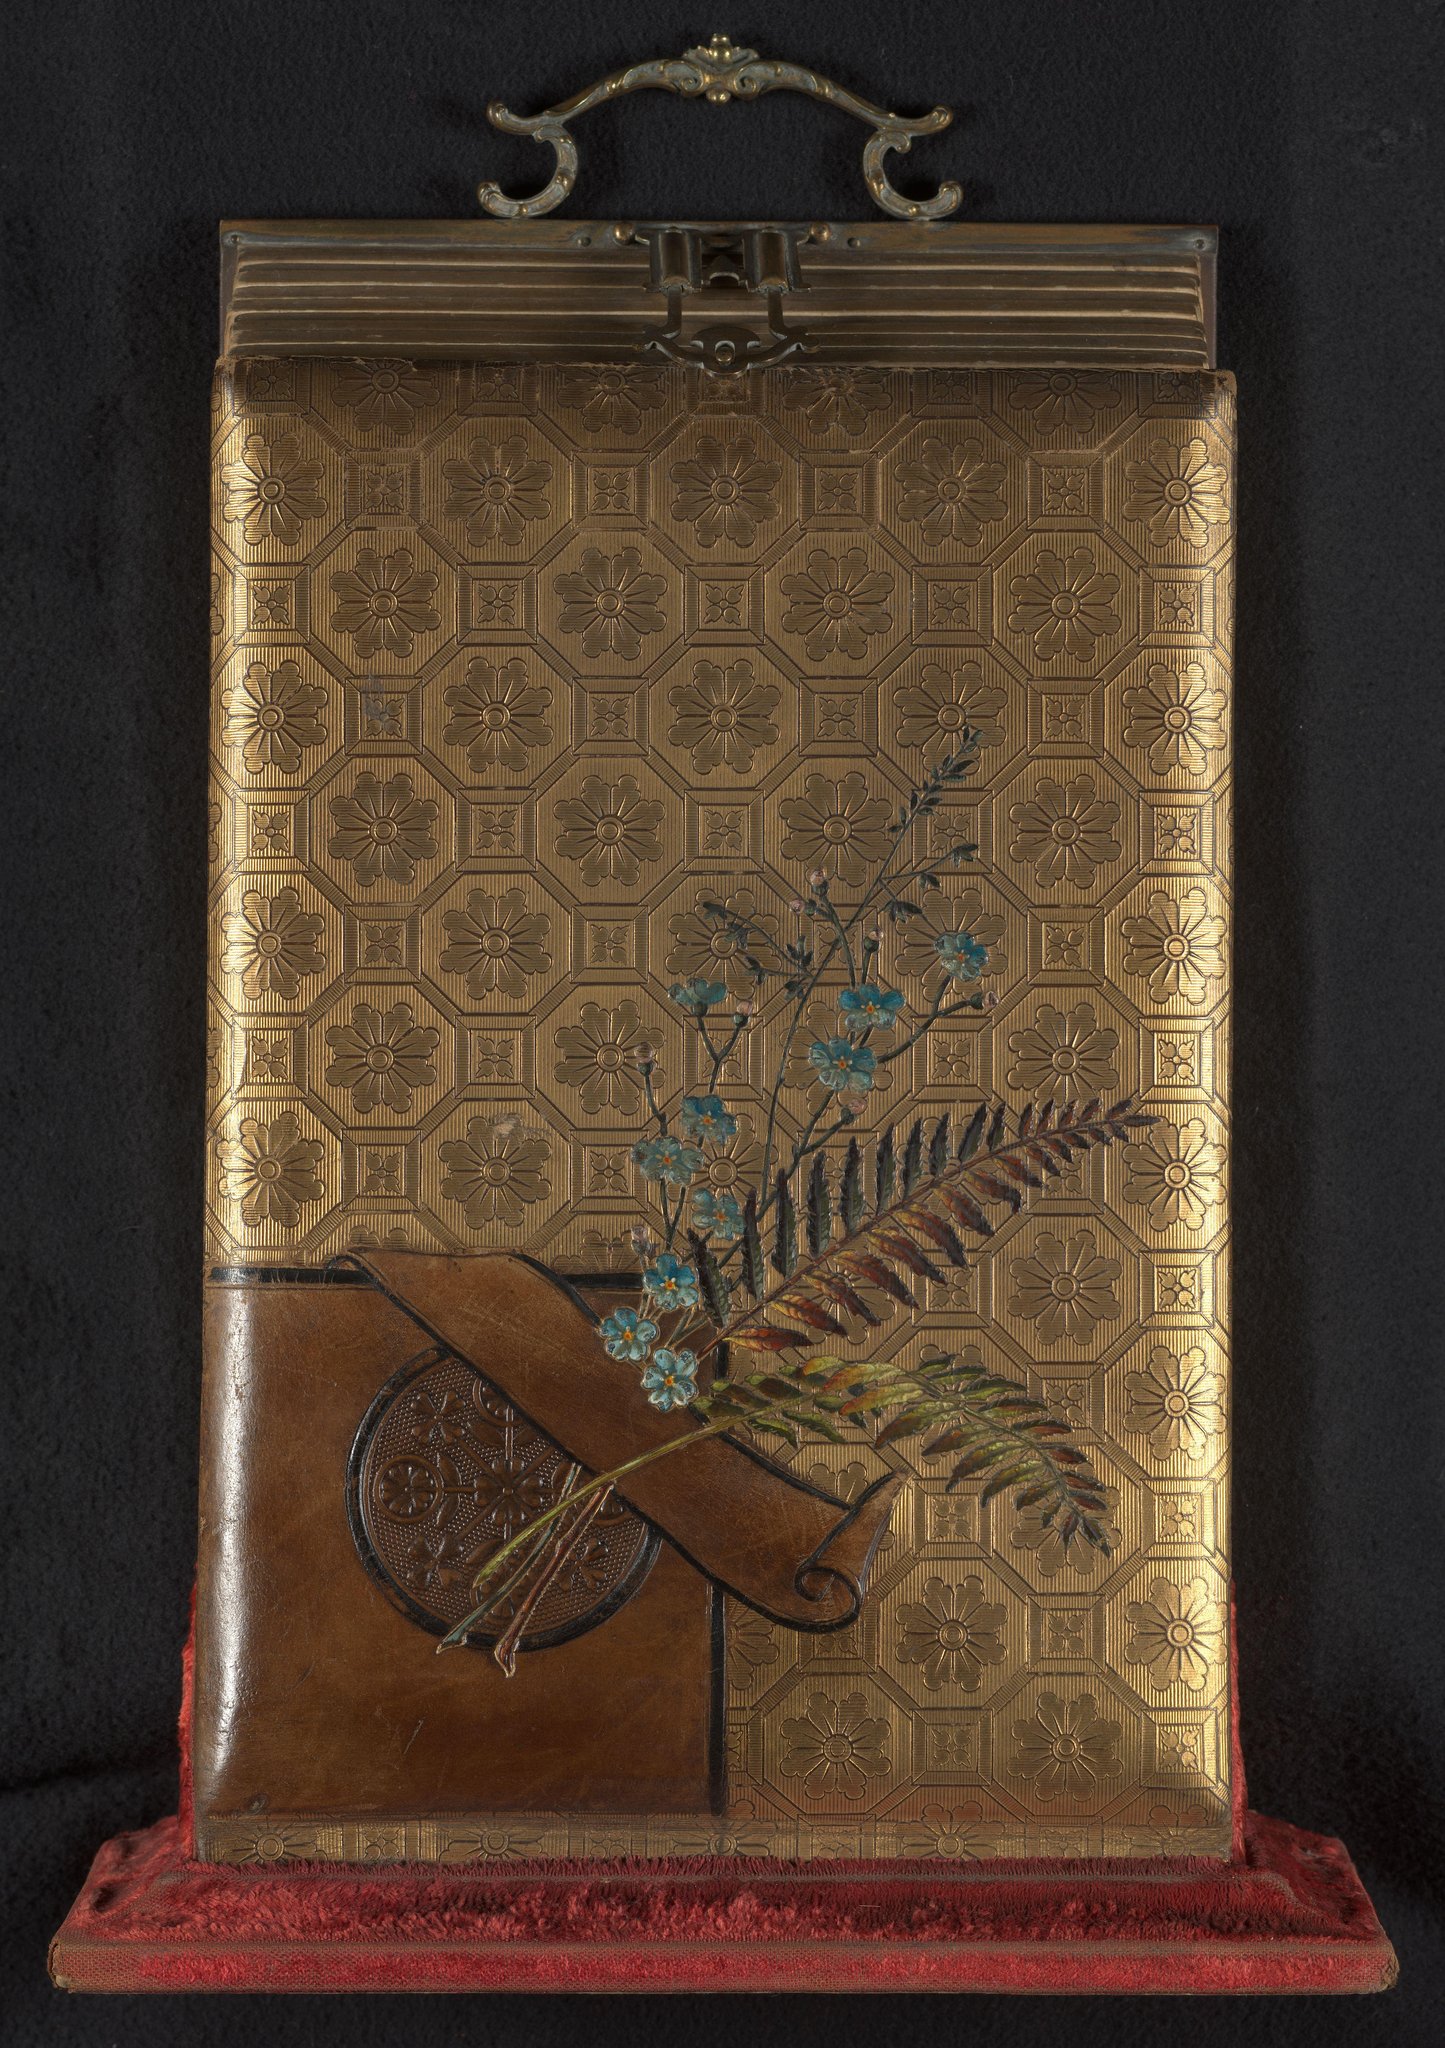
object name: photograph album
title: Zweeds familiealbum met 55 foto's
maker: Anonymous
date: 1860-1900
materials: cardboard, leather, metal, paper, photographic support, textile, wood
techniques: albumen print, chromolithography, decorated paper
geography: sweden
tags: the hague, historical persons - bb - woman, child, historical persons, queen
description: Fotoalbum met 26 pagina's met in totaal 55 foto's. Het album bevat 15 kabinetfoto's en 40 cartes-de-visite in met gouden lijnen of afbeeldingen in chromolithografie omkaderde passe-partouts. Afgebeeld zijn portretten van onbekende mannen, vrouwen en kinderen en een portret van Louise, koningin van Zweden. De foto's zijn gemaakt door verschillende Zweedse fotografen, waaronder August Roesler en A. Anderzon. Van 21 foto's is de fotograaf anoniem.